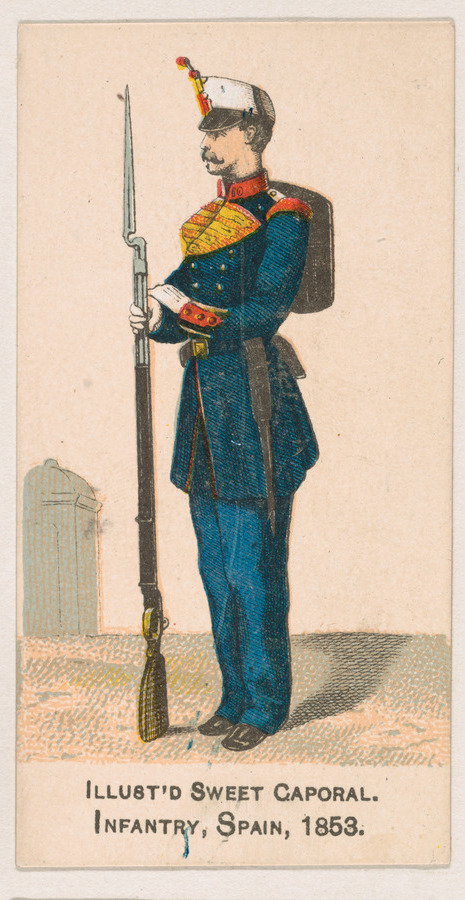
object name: print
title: Infantry, Spain, 1853, from the Military Series (N224) issued by Kinney Tobacco Company to promote Sweet Caporal Cigarettes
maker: kinney brothers tobacco company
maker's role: publisher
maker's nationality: american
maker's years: 1869-2011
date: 1888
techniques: color lithograph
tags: military,men,profiles